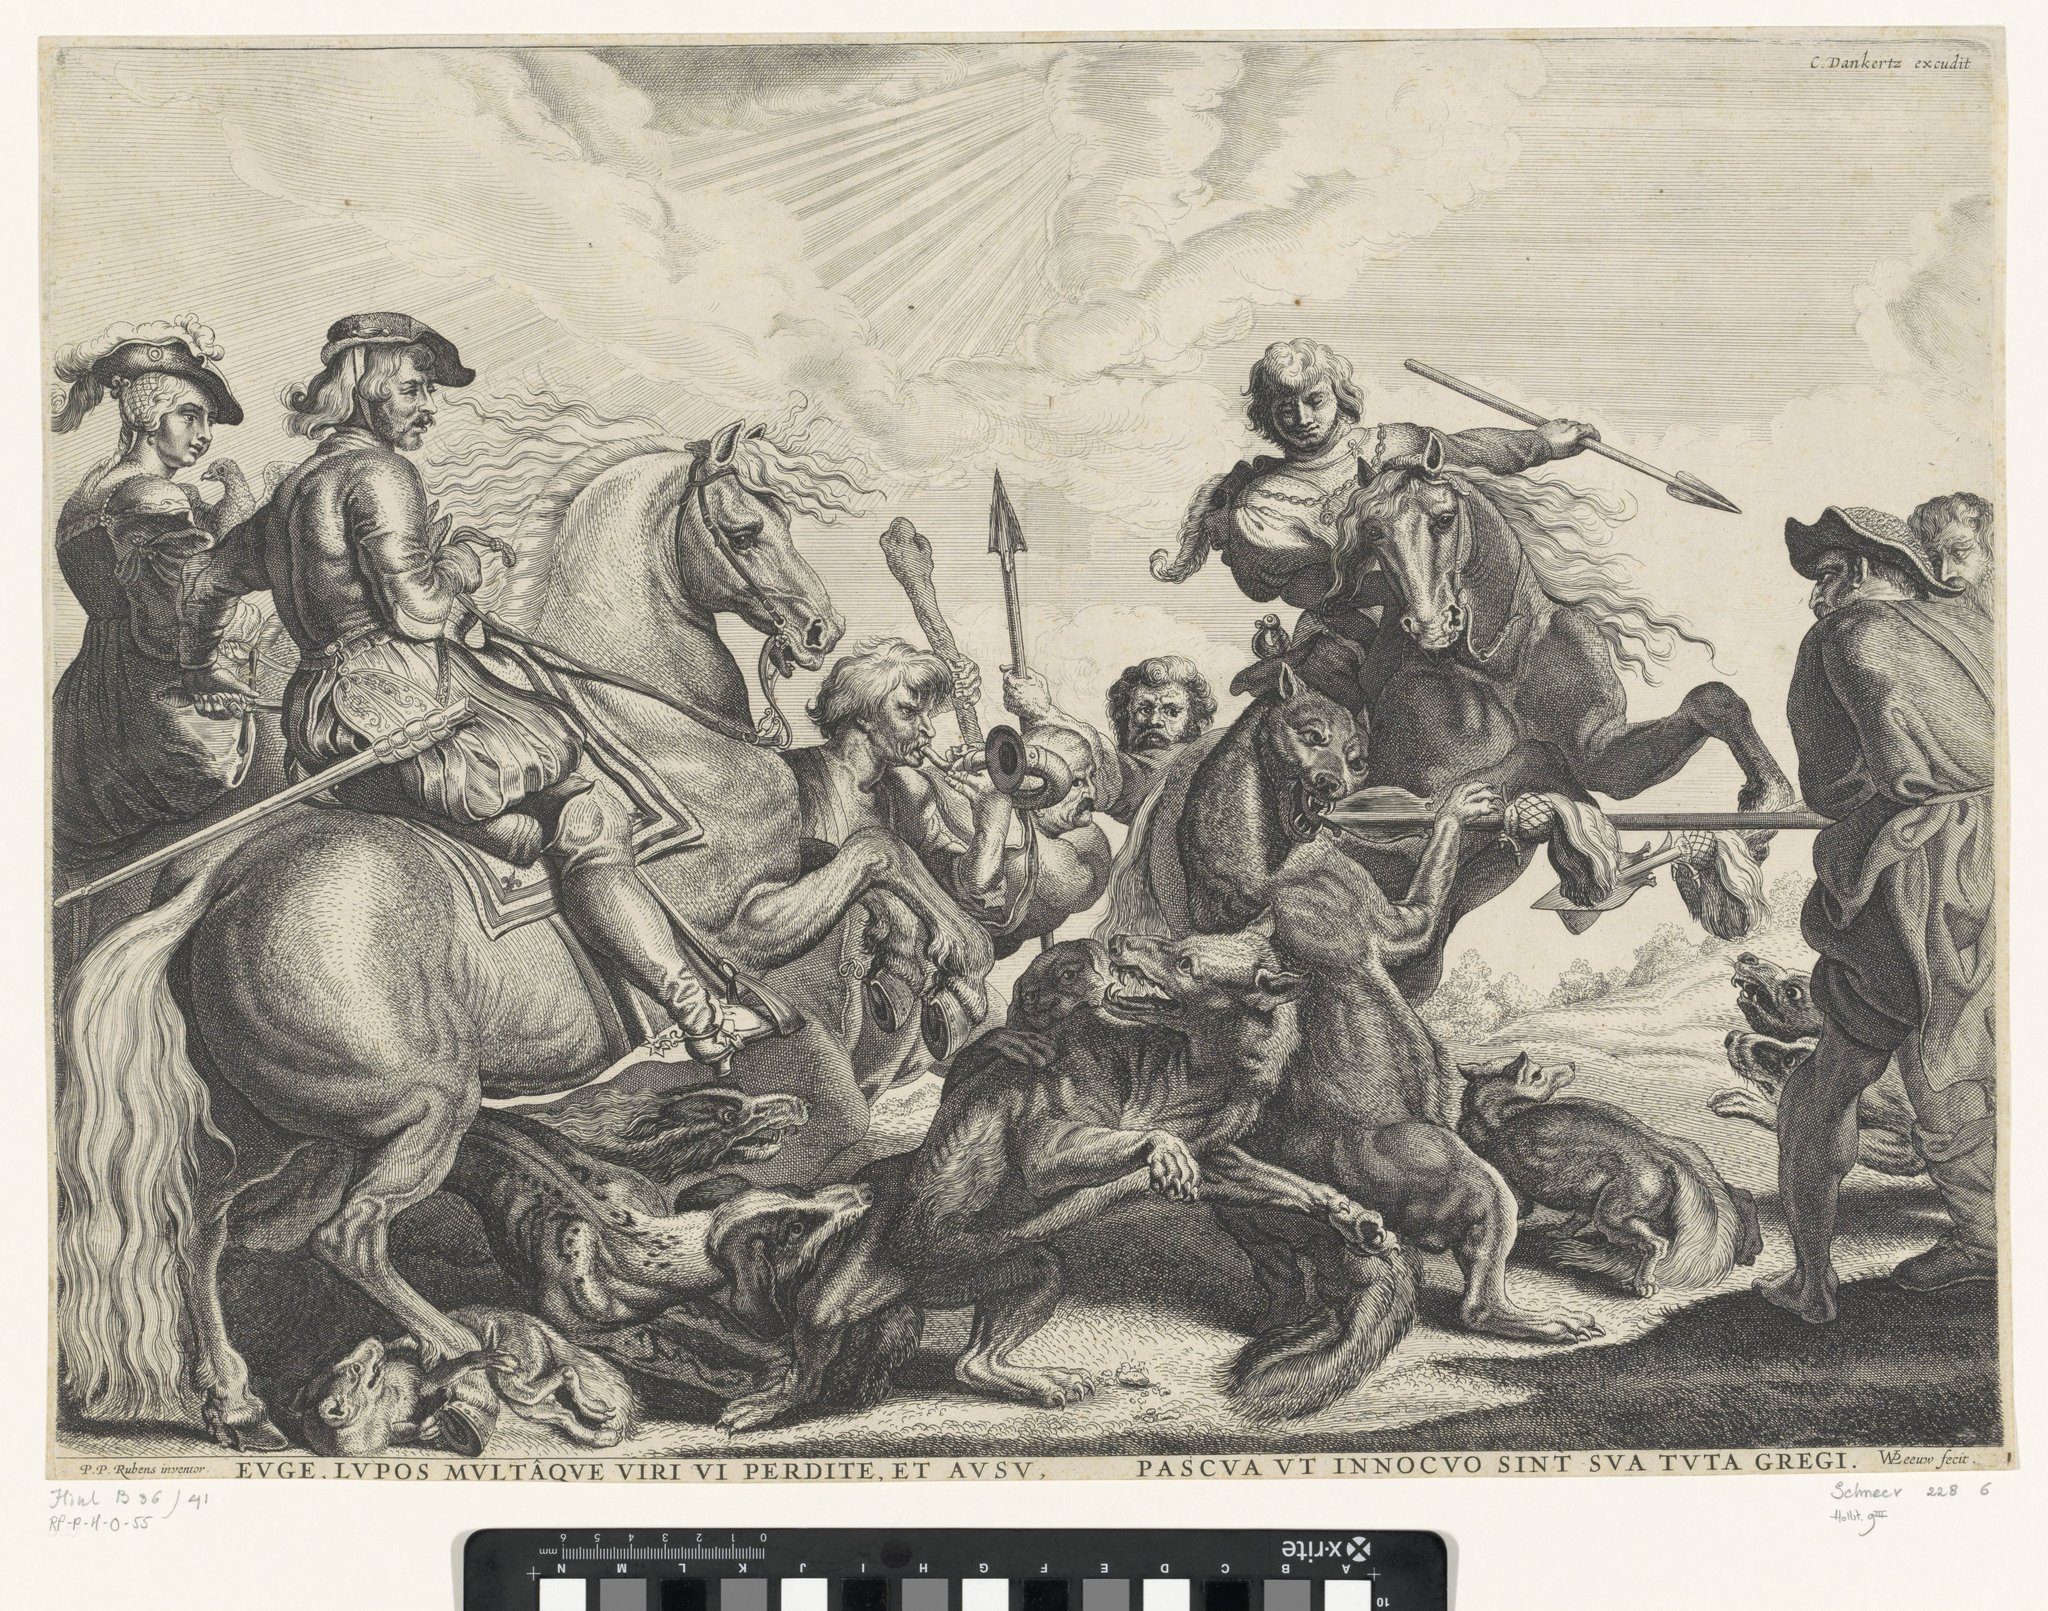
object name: print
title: Wolvenjacht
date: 1630-1718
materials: paper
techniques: engraving, etching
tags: hunt ~ mammals, beasts of prey, predatory animals: fox, beasts of prey, predatory animals: wolf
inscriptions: collector's mark: Lugt 11, number: ‘1’, collector's mark: Lugt 10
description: Twee wolven worden omringd door honden en jagers. Enkele jagers steken de dieren met speren. Links en rechts van de wolven opgejaagde vossen. Uiterst links zit een vrouw met valk te paard. In de marge een regel tekst in Latijn.